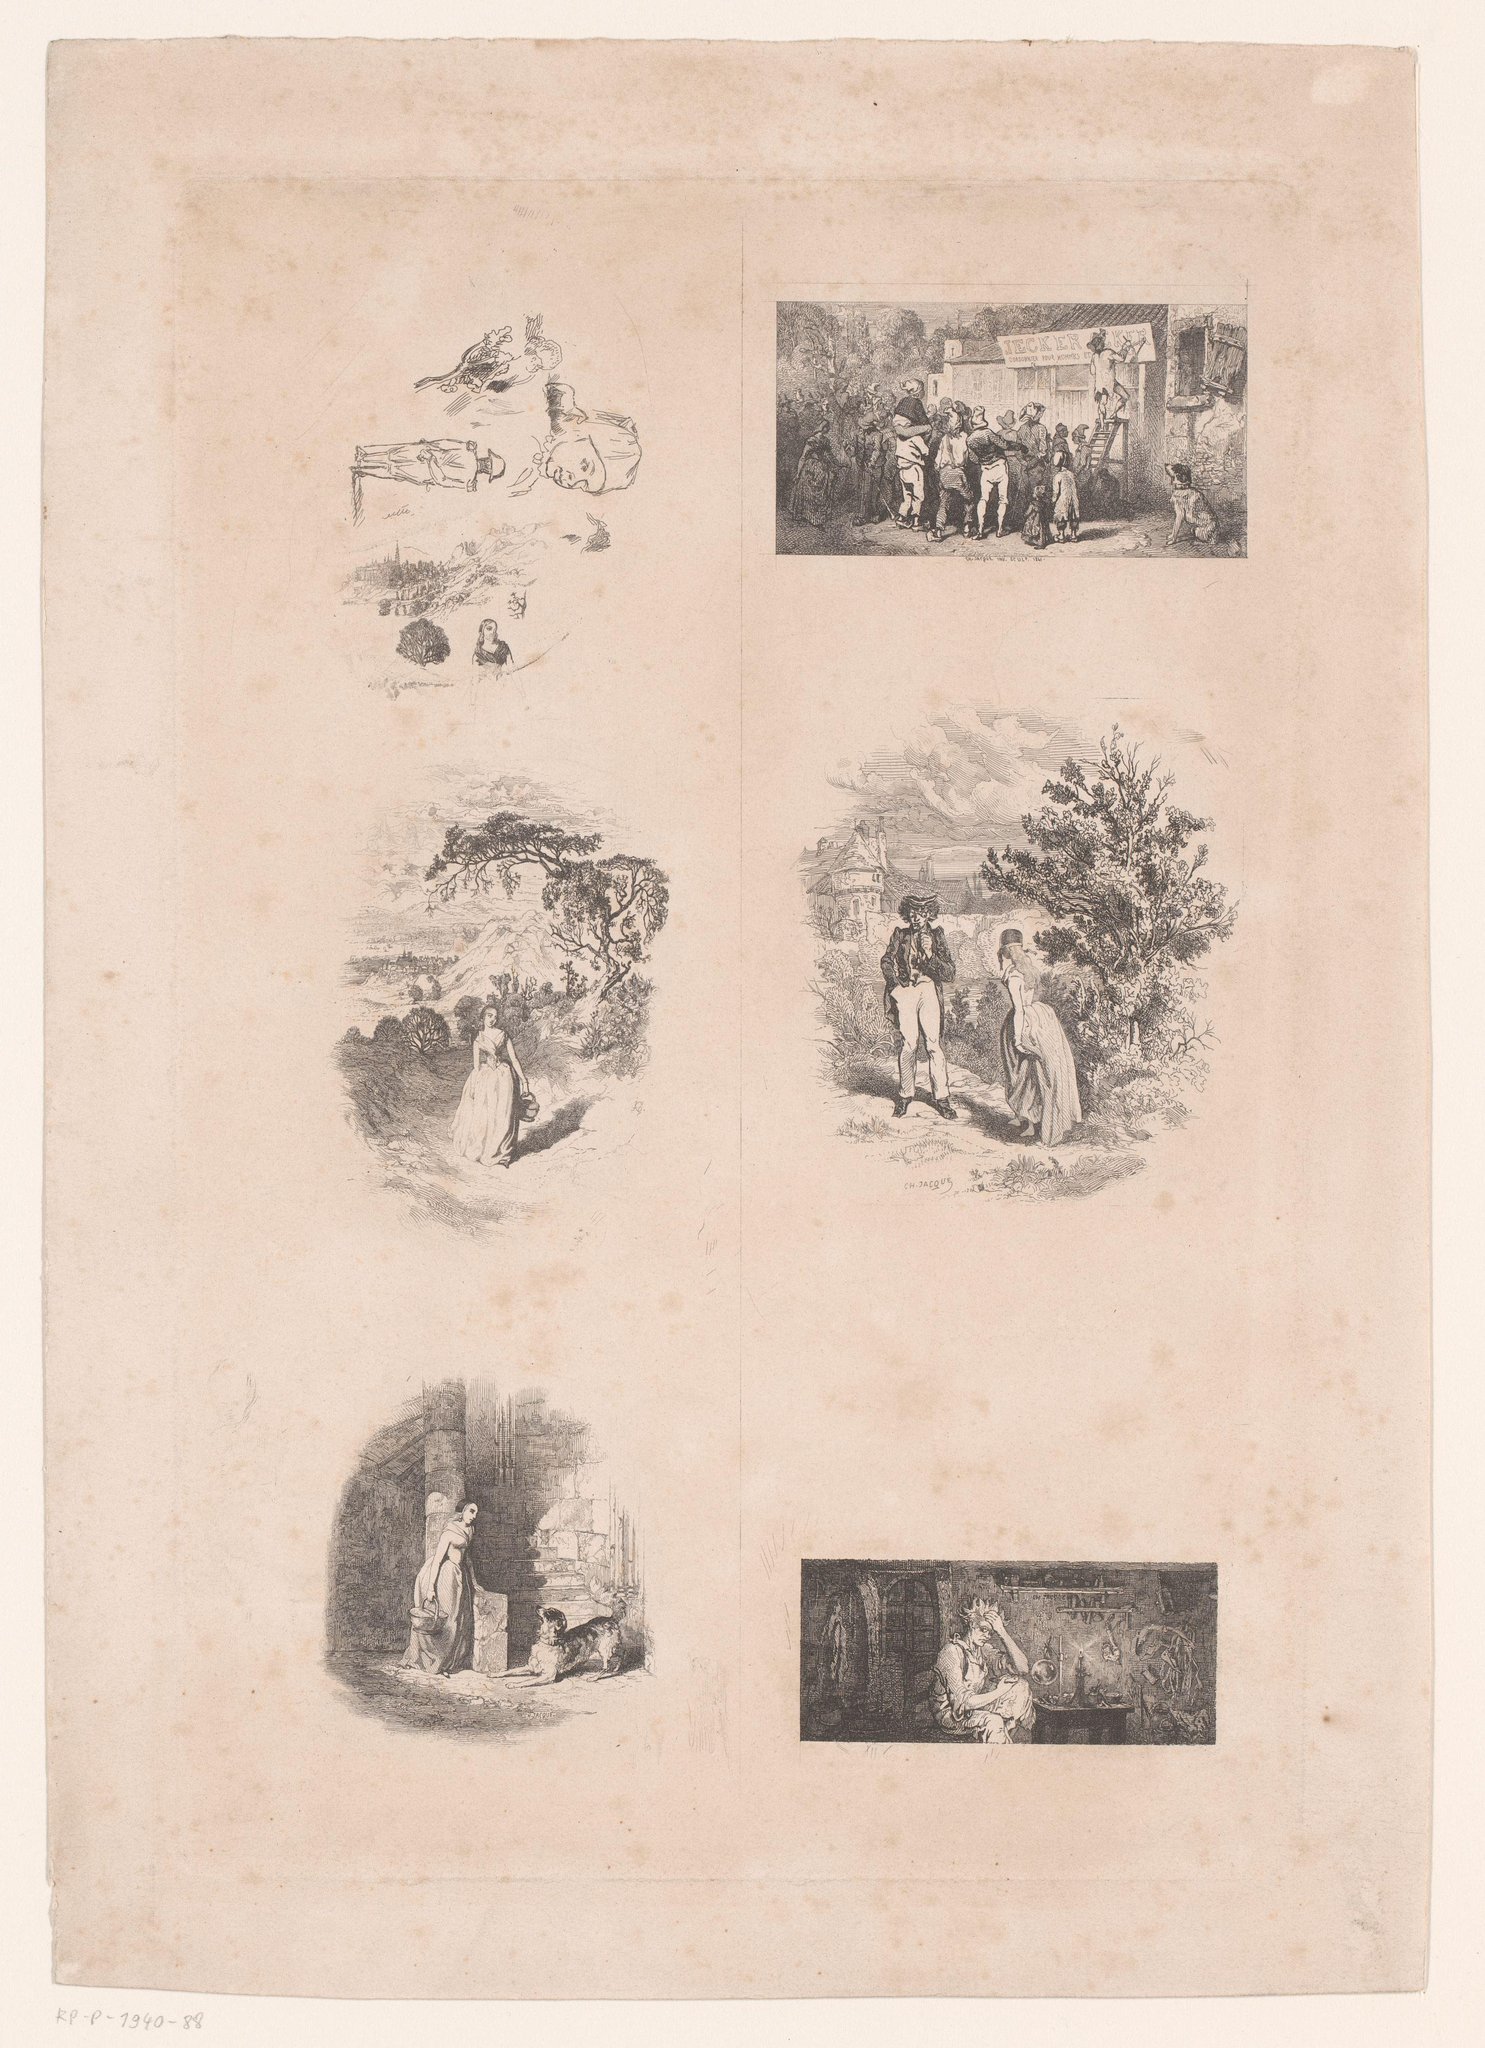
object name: book illustration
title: Zes voorstellingen uit Madame Acker van Giavarni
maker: charles emile jacque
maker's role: draughtsman, painter, print maker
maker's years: 1813-1894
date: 1842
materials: paper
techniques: etching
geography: france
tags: adult woman, adult man, dog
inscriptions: collector's mark: Lugt 2166, collector's mark: Lugt 2760